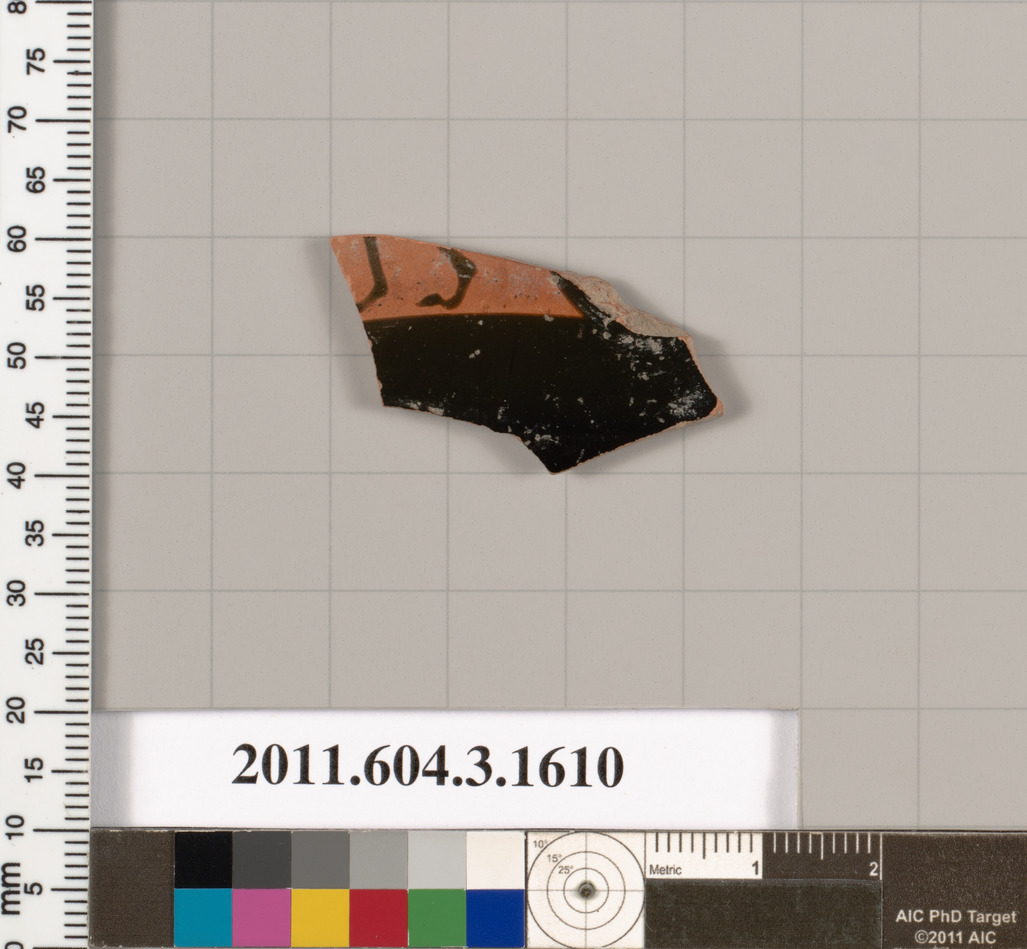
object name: kylix fragment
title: Terracotta fragment of a kylix: Band cup (drinking cup)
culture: greek, attic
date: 550-526 BCE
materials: terracotta